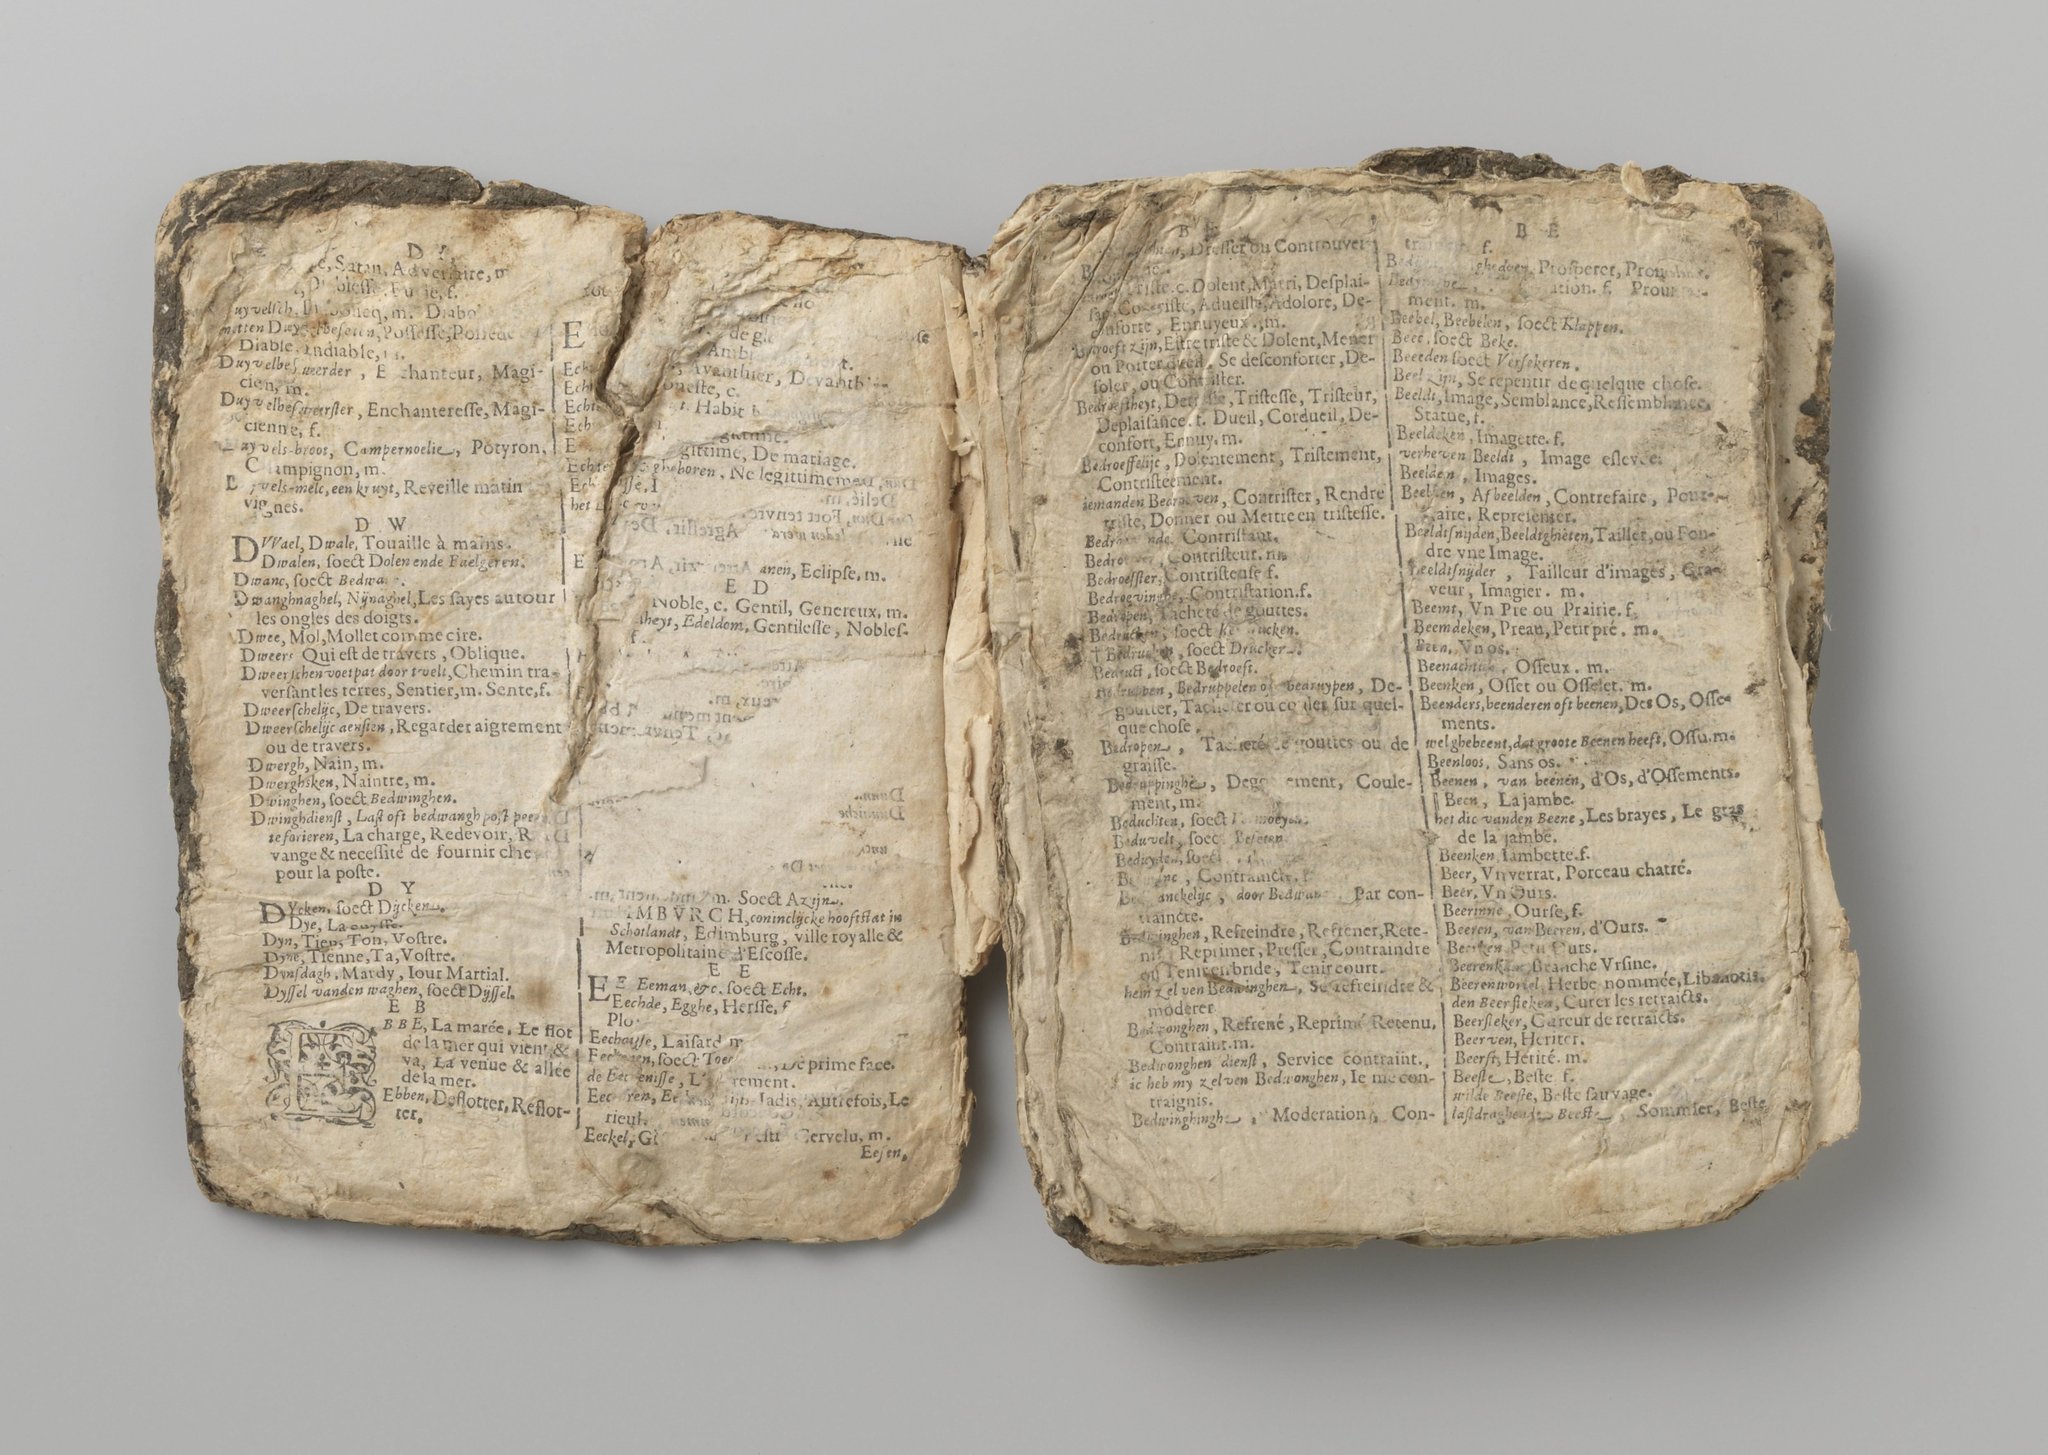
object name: dictionary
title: Nederlands-frans woordenboek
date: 1587-1589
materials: paper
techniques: printing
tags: willem barendsz., amsterdam, jacob van heemskerck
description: Nederlands-Frans woordenboek. Volgens De Jonge: "Dictionaire ou Promptuaire Flameng-Francois, très-ample et tres copieux; de nouveau composè, embelli, augmentè et enrichi d'un nombre presque infini de vocables, dictions, sentences, proverbes et phrases très utiles, et très exquises, par Elcie Edouard Leon Mellema, & c. à Anvers, chez Jan Waesbergue en la camerstrate à l'Escu de Flandres", opgedragen aan de vroedschap van Haarlem.